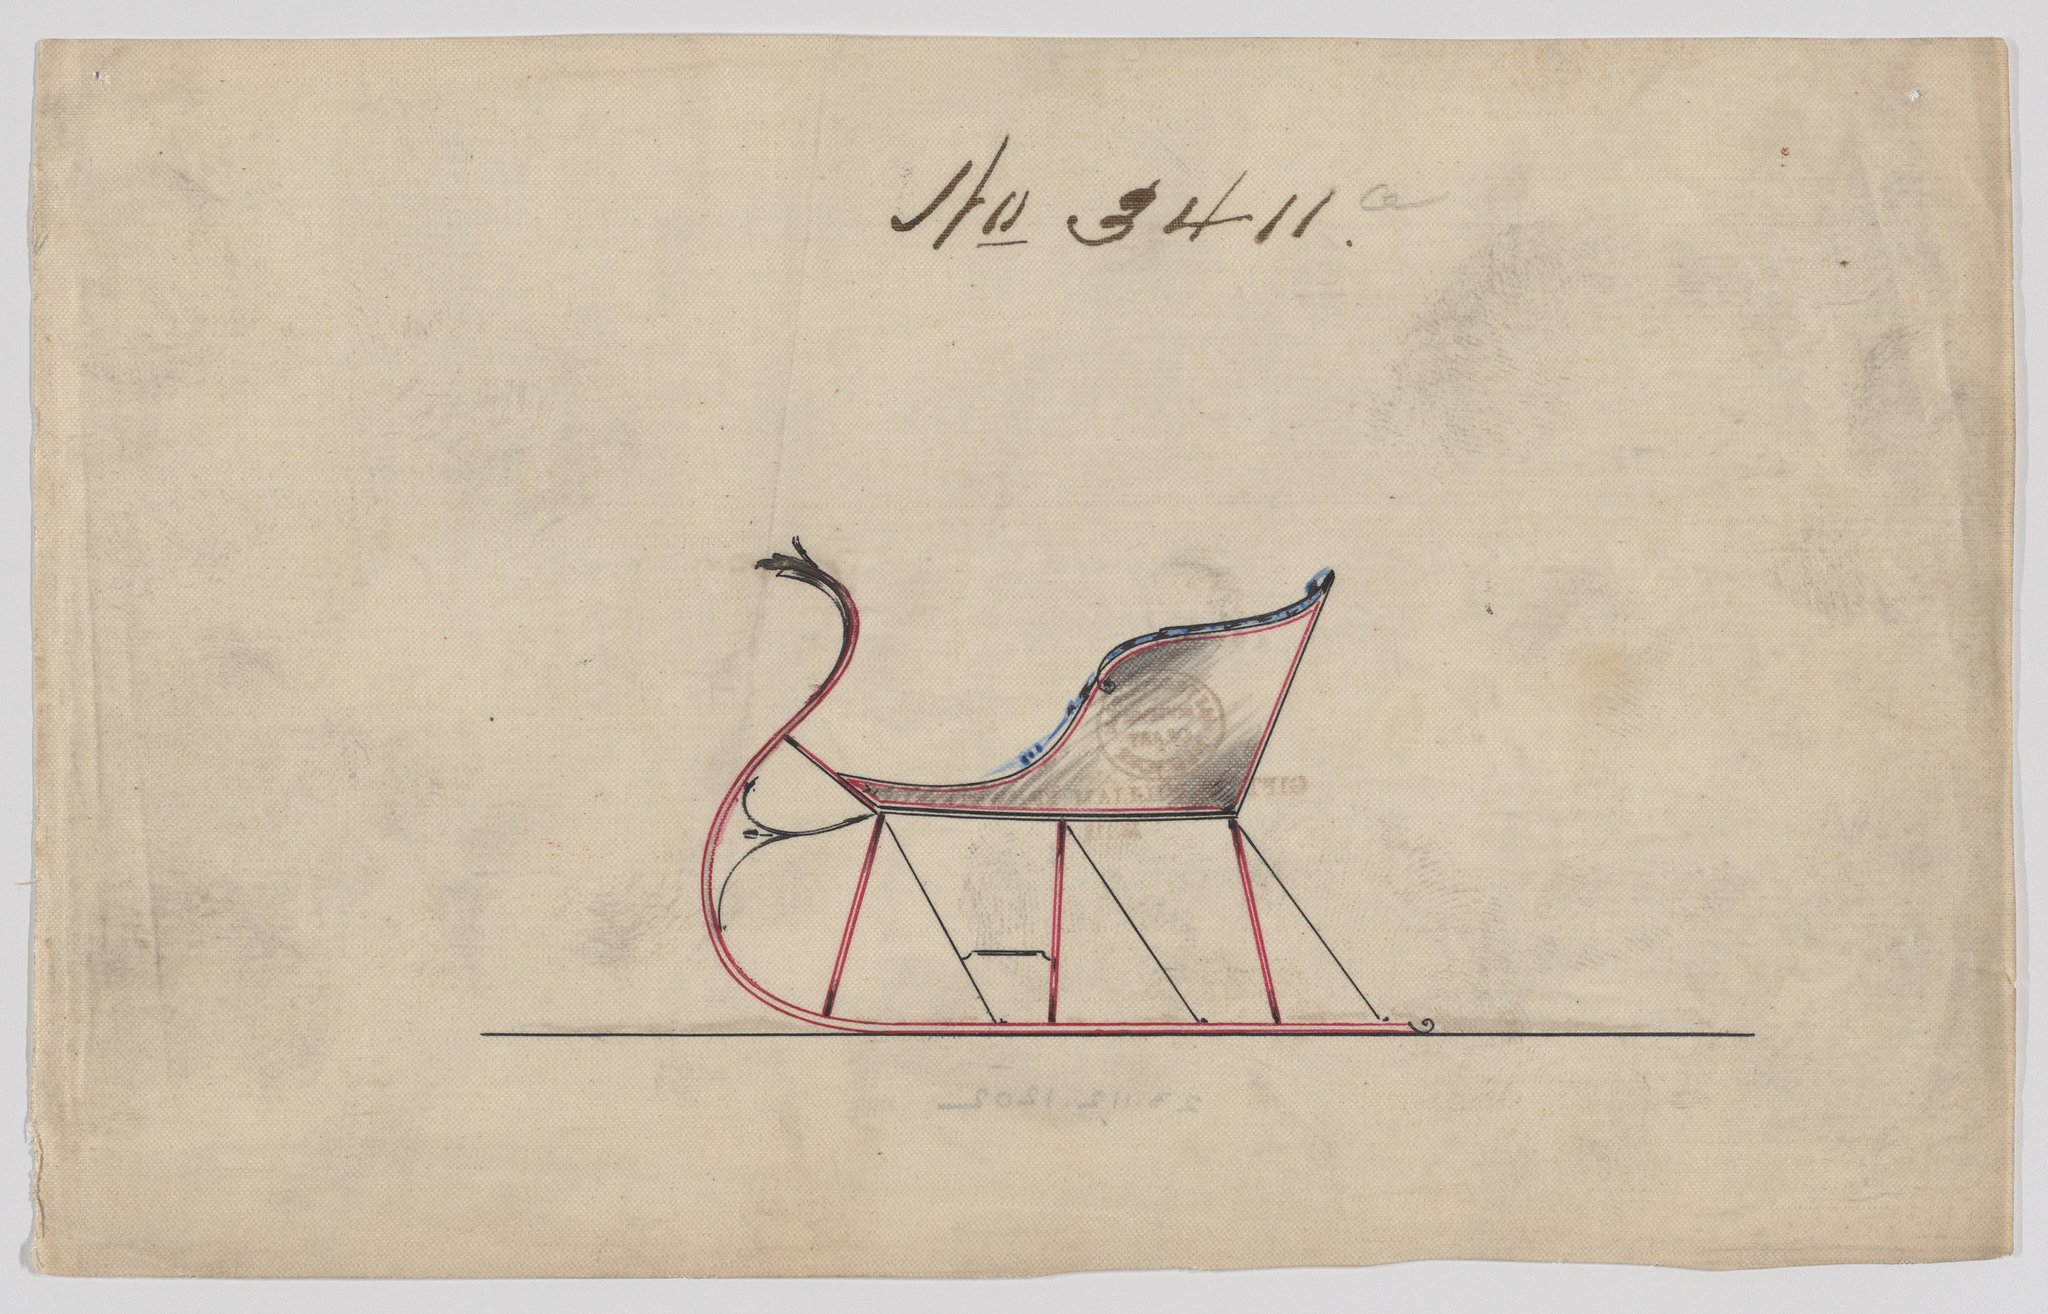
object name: drawing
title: Cutter # 3411a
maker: brewster & co.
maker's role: manufacturer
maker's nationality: american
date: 1878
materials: ink, paper, watercolor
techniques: pen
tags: sleighs